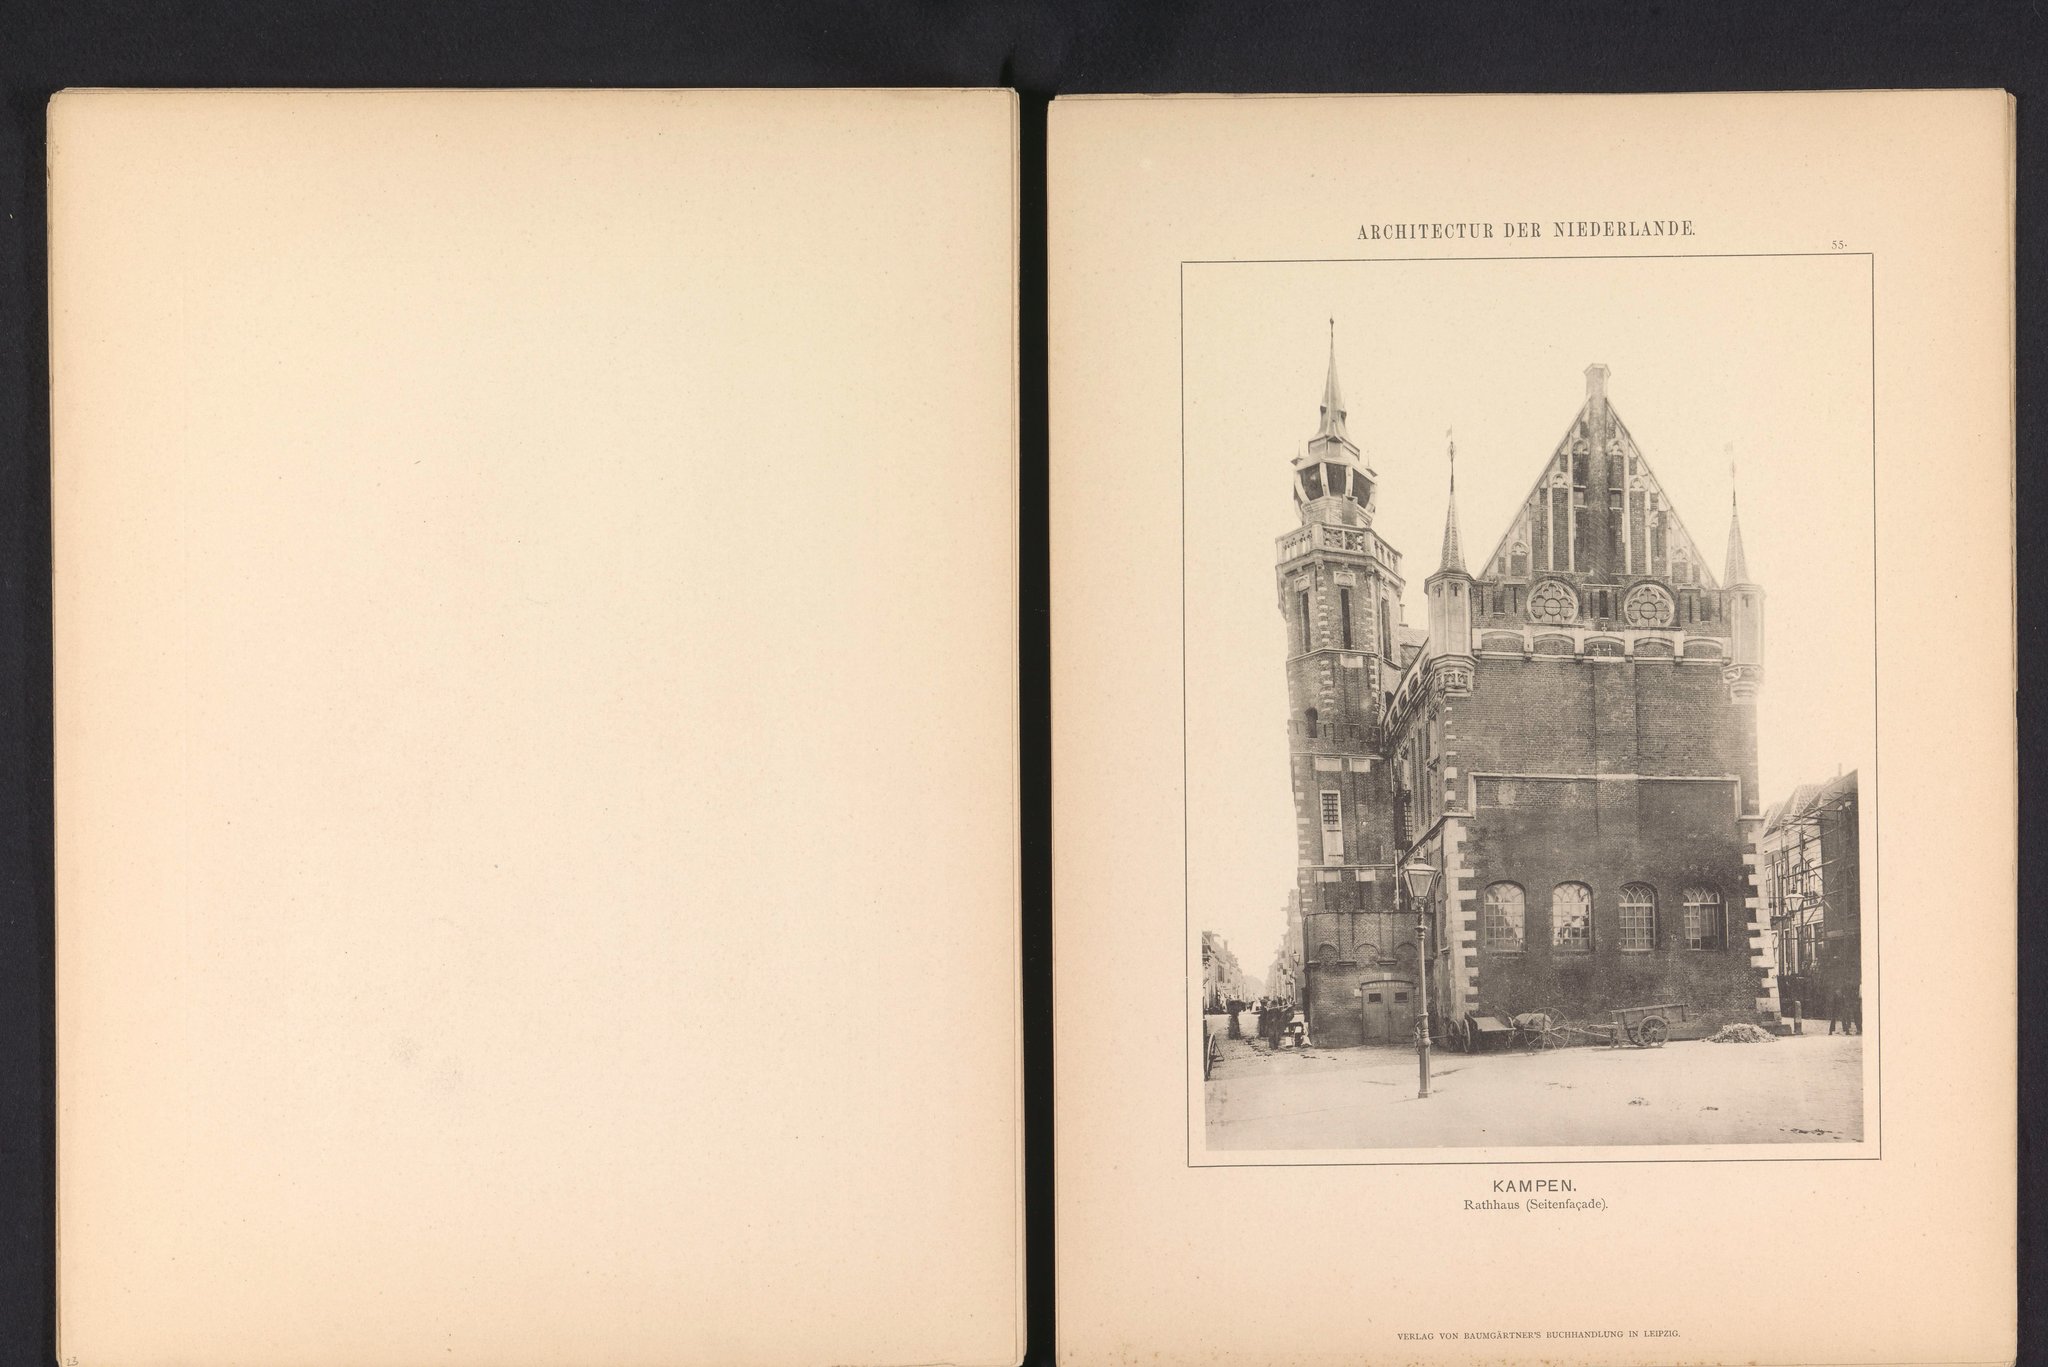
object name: photomechanical print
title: Kampen. Rathhaus (Seitenfaçade)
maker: Anonymous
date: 1884-1894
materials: paper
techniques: photograph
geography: leipzig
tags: townhall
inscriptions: number: ‘55.’